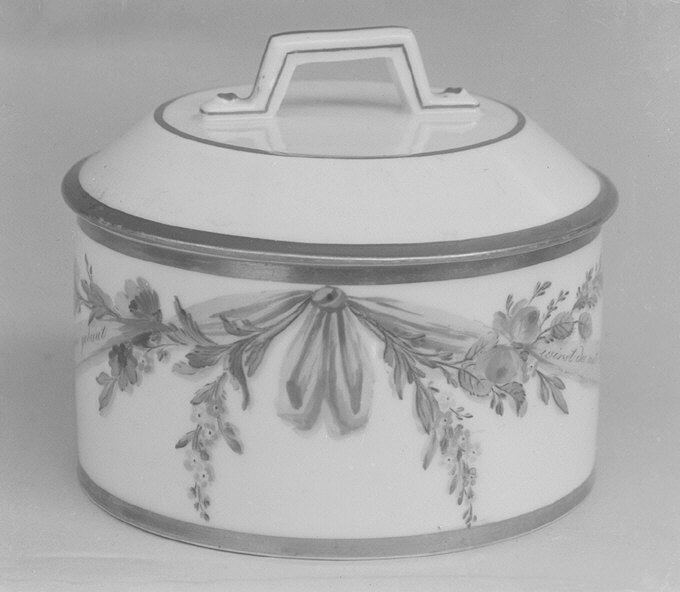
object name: bowl with cover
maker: gotha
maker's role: factory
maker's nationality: german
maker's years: 1757-1900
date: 1767-1800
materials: hard paste porcelain